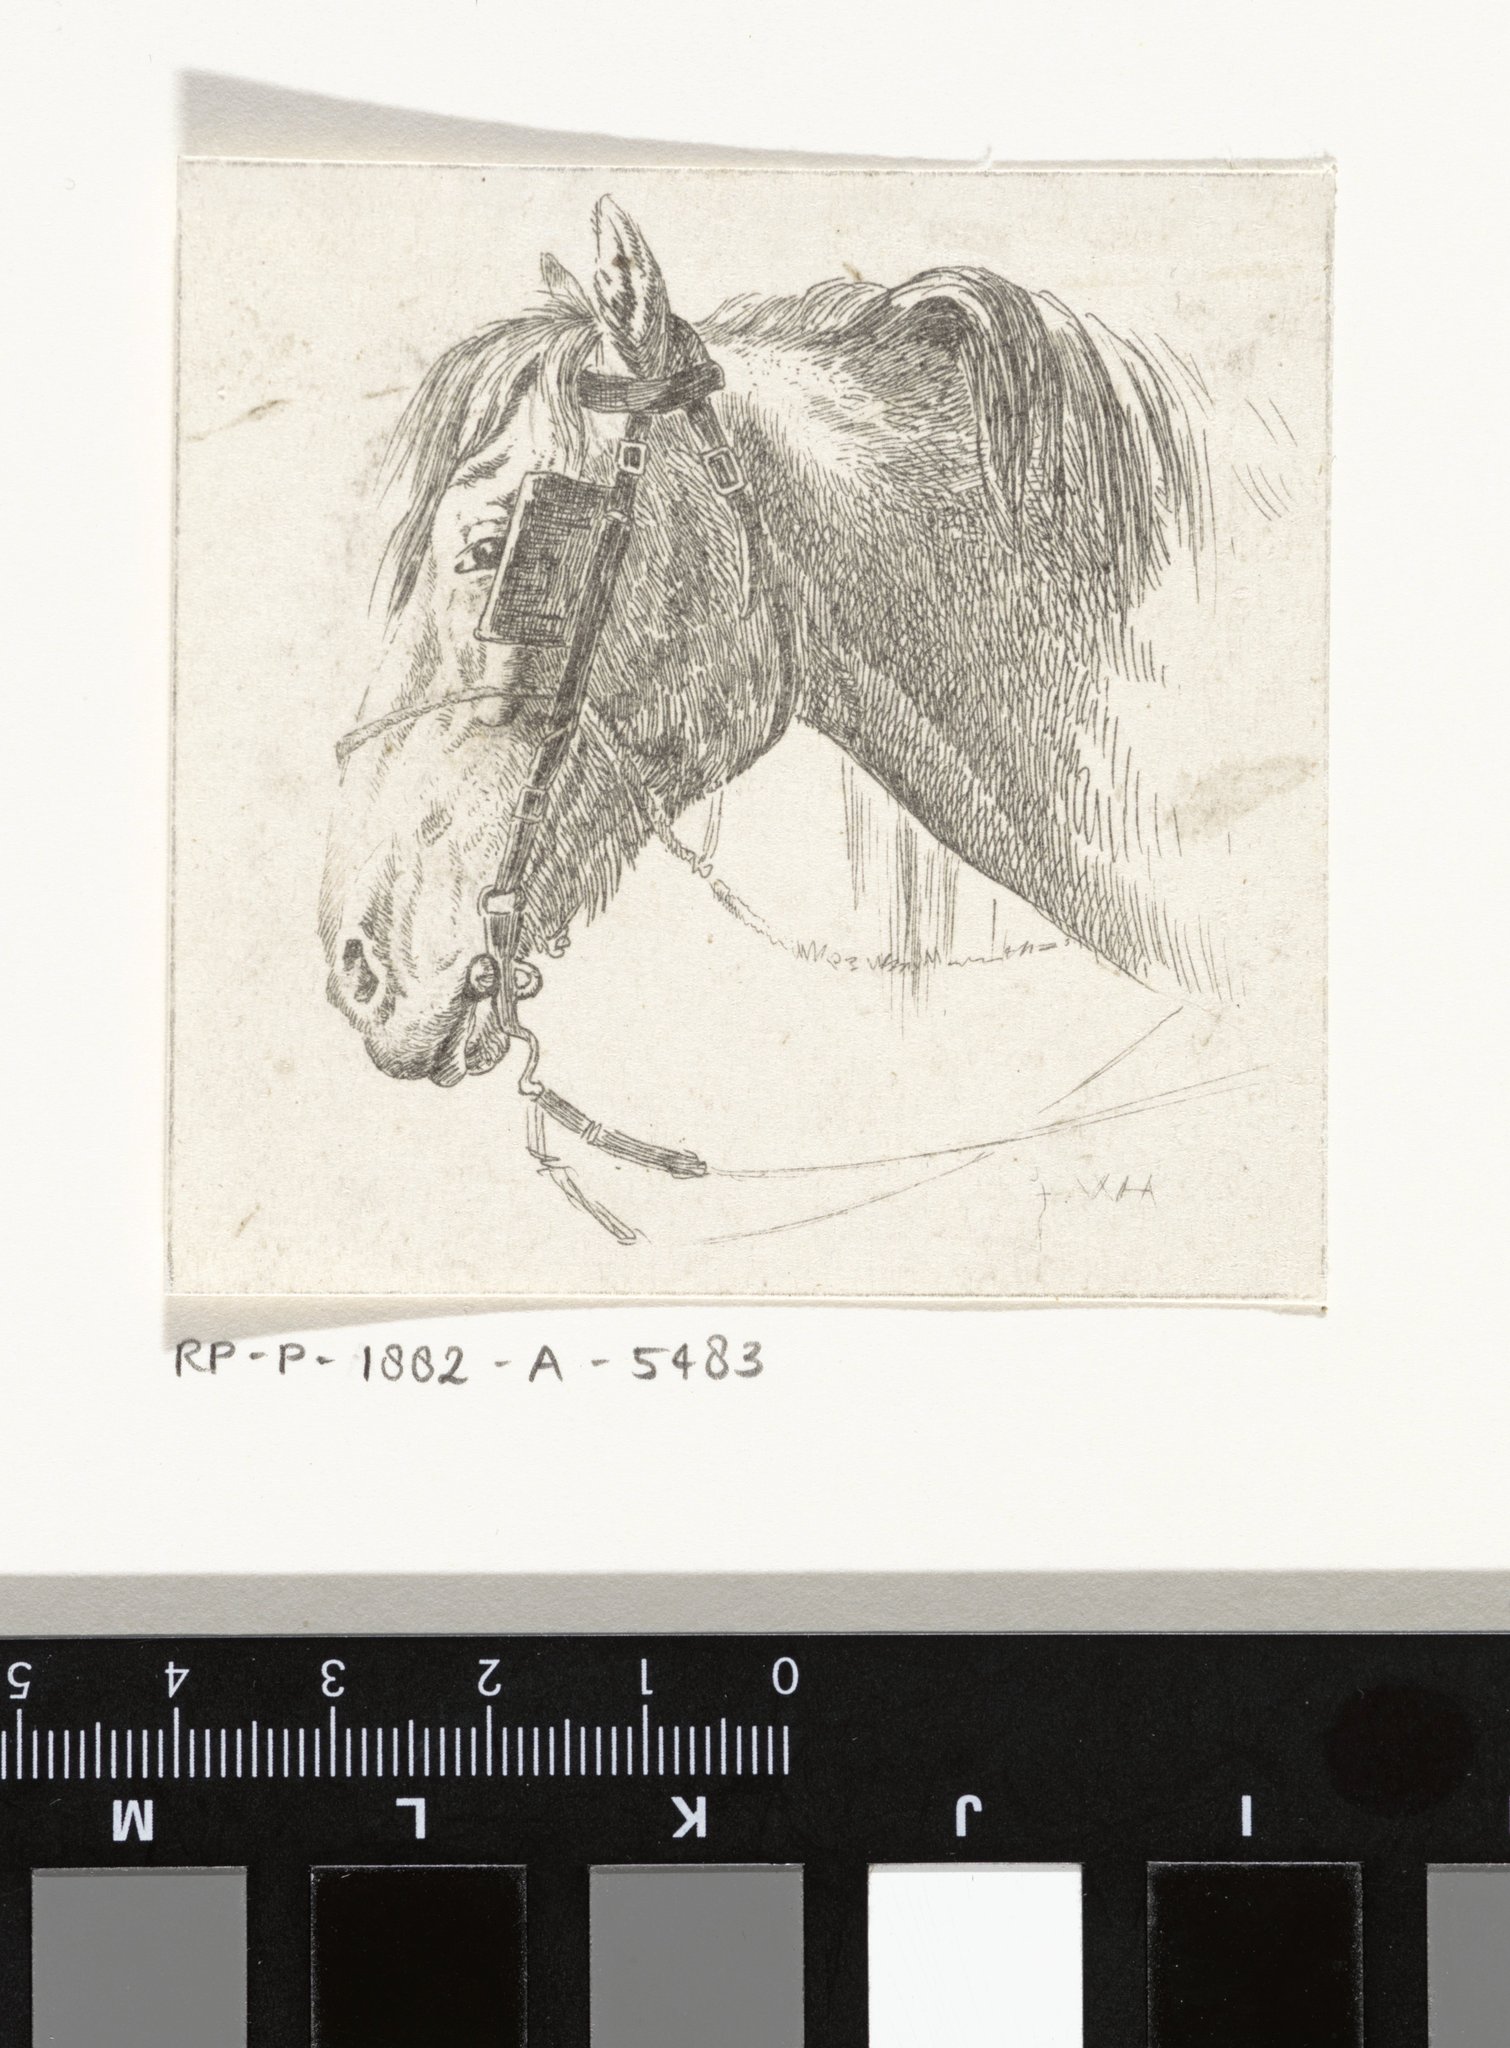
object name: print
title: Paardenhoofd met hoofdstel met oogkleppen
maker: abraham hendrik winter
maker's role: painter, print maker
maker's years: 1800-1861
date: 1815-1860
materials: paper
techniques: printmaking, etching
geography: utrecht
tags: horse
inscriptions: collector's mark: Lugt 2228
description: Paardenhoofd naar links met een hoofdstel met oogkleppen.